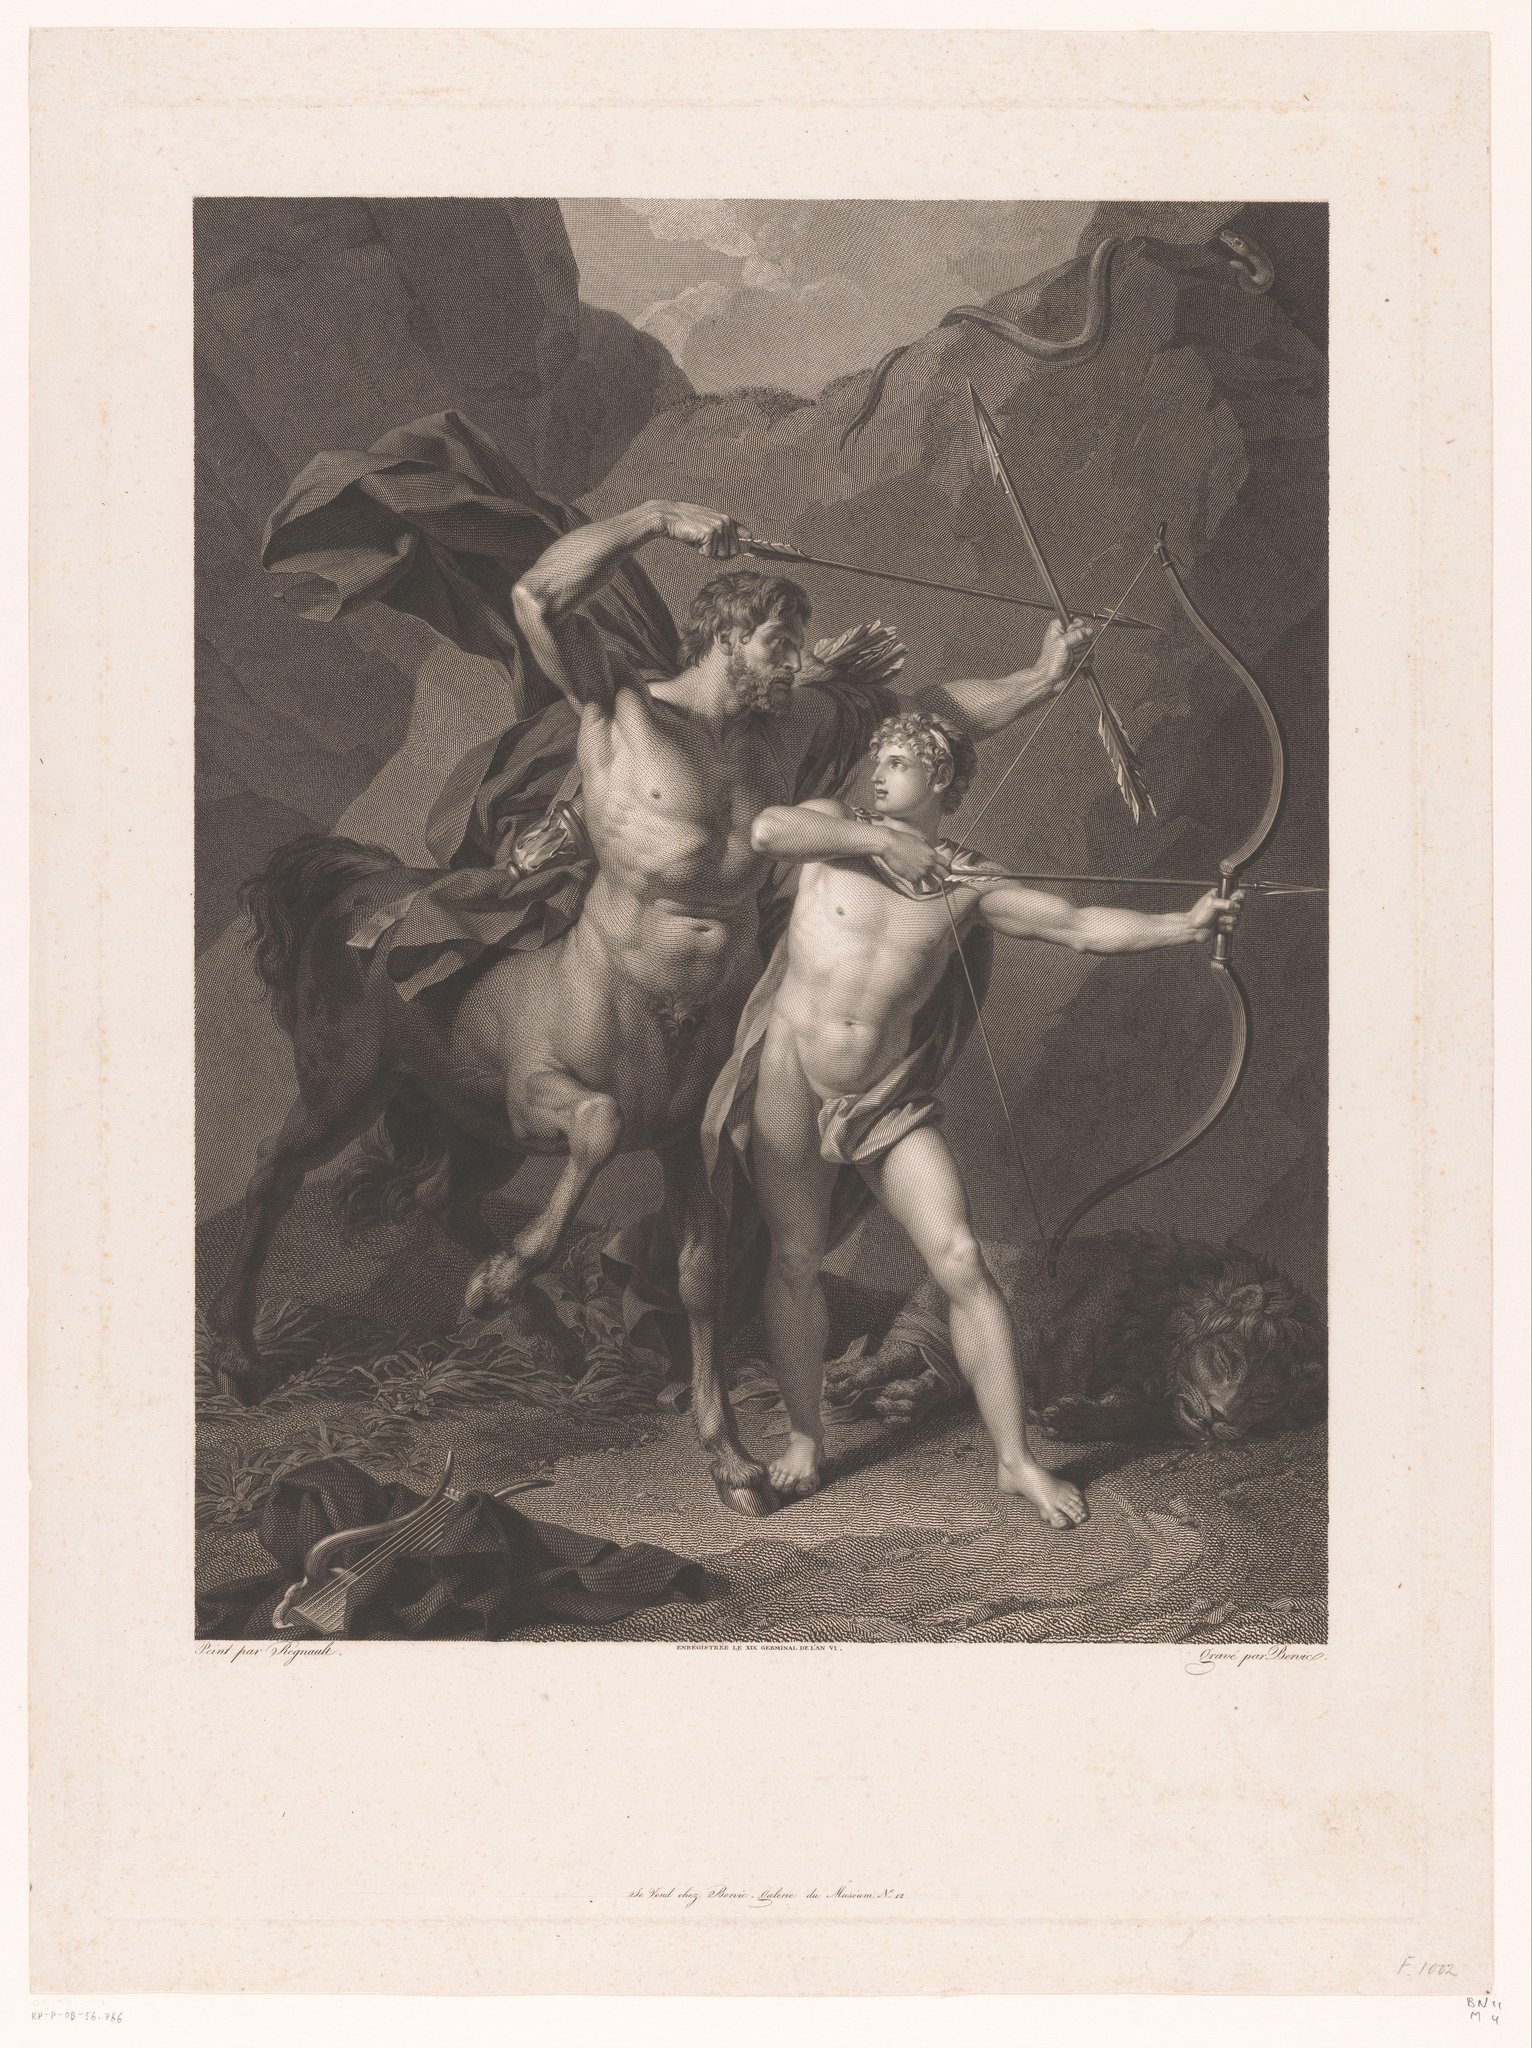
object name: print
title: Chiron onderricht Achilles in het boogschieten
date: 1766-1822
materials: paper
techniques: engraving, etching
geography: paris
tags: the education of achilles by chiron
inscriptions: collector's mark: Lugt 12